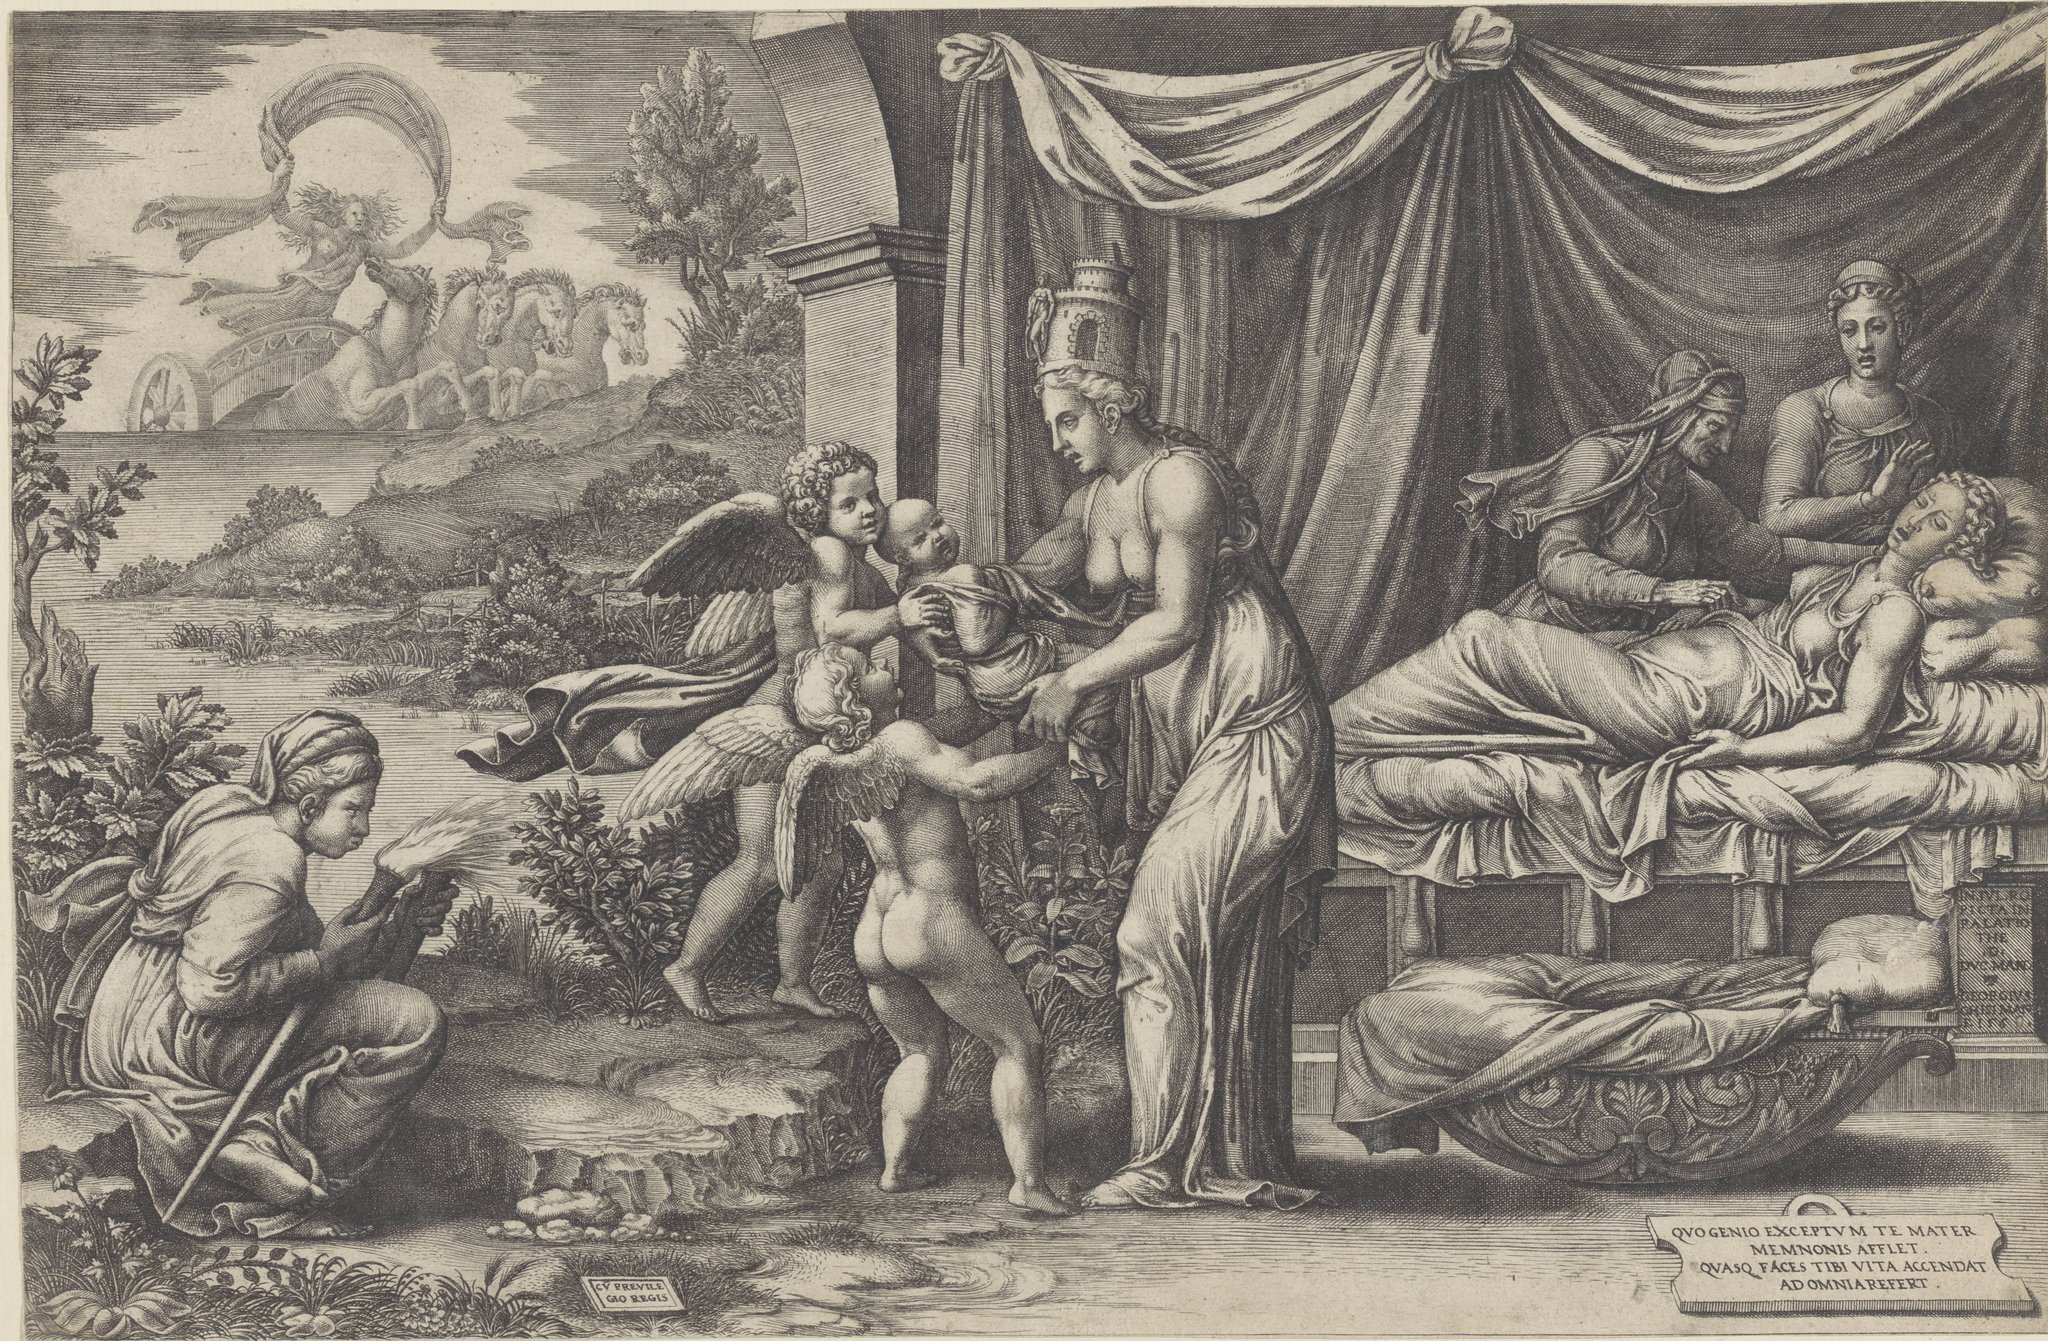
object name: print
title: Allegorie op de Geboorte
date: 1560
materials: paper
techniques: engraving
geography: italy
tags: apollo as sun-god, i.e. sol (helius), titan, woman giving birth (lying-in), cupids: 'amores', 'amoretti', 'putti'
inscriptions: collector's mark: Lugt 240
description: Een vrouw geeft een pasgeboren baby aan twee putti. Links zit een vrouw met een brandende fakkel. Rechts ligt een vrouw die zojuist is bevallen. Naast het bed staan twee vrouwen. Op de achtergrond Apollo op zijn zonnewagen.